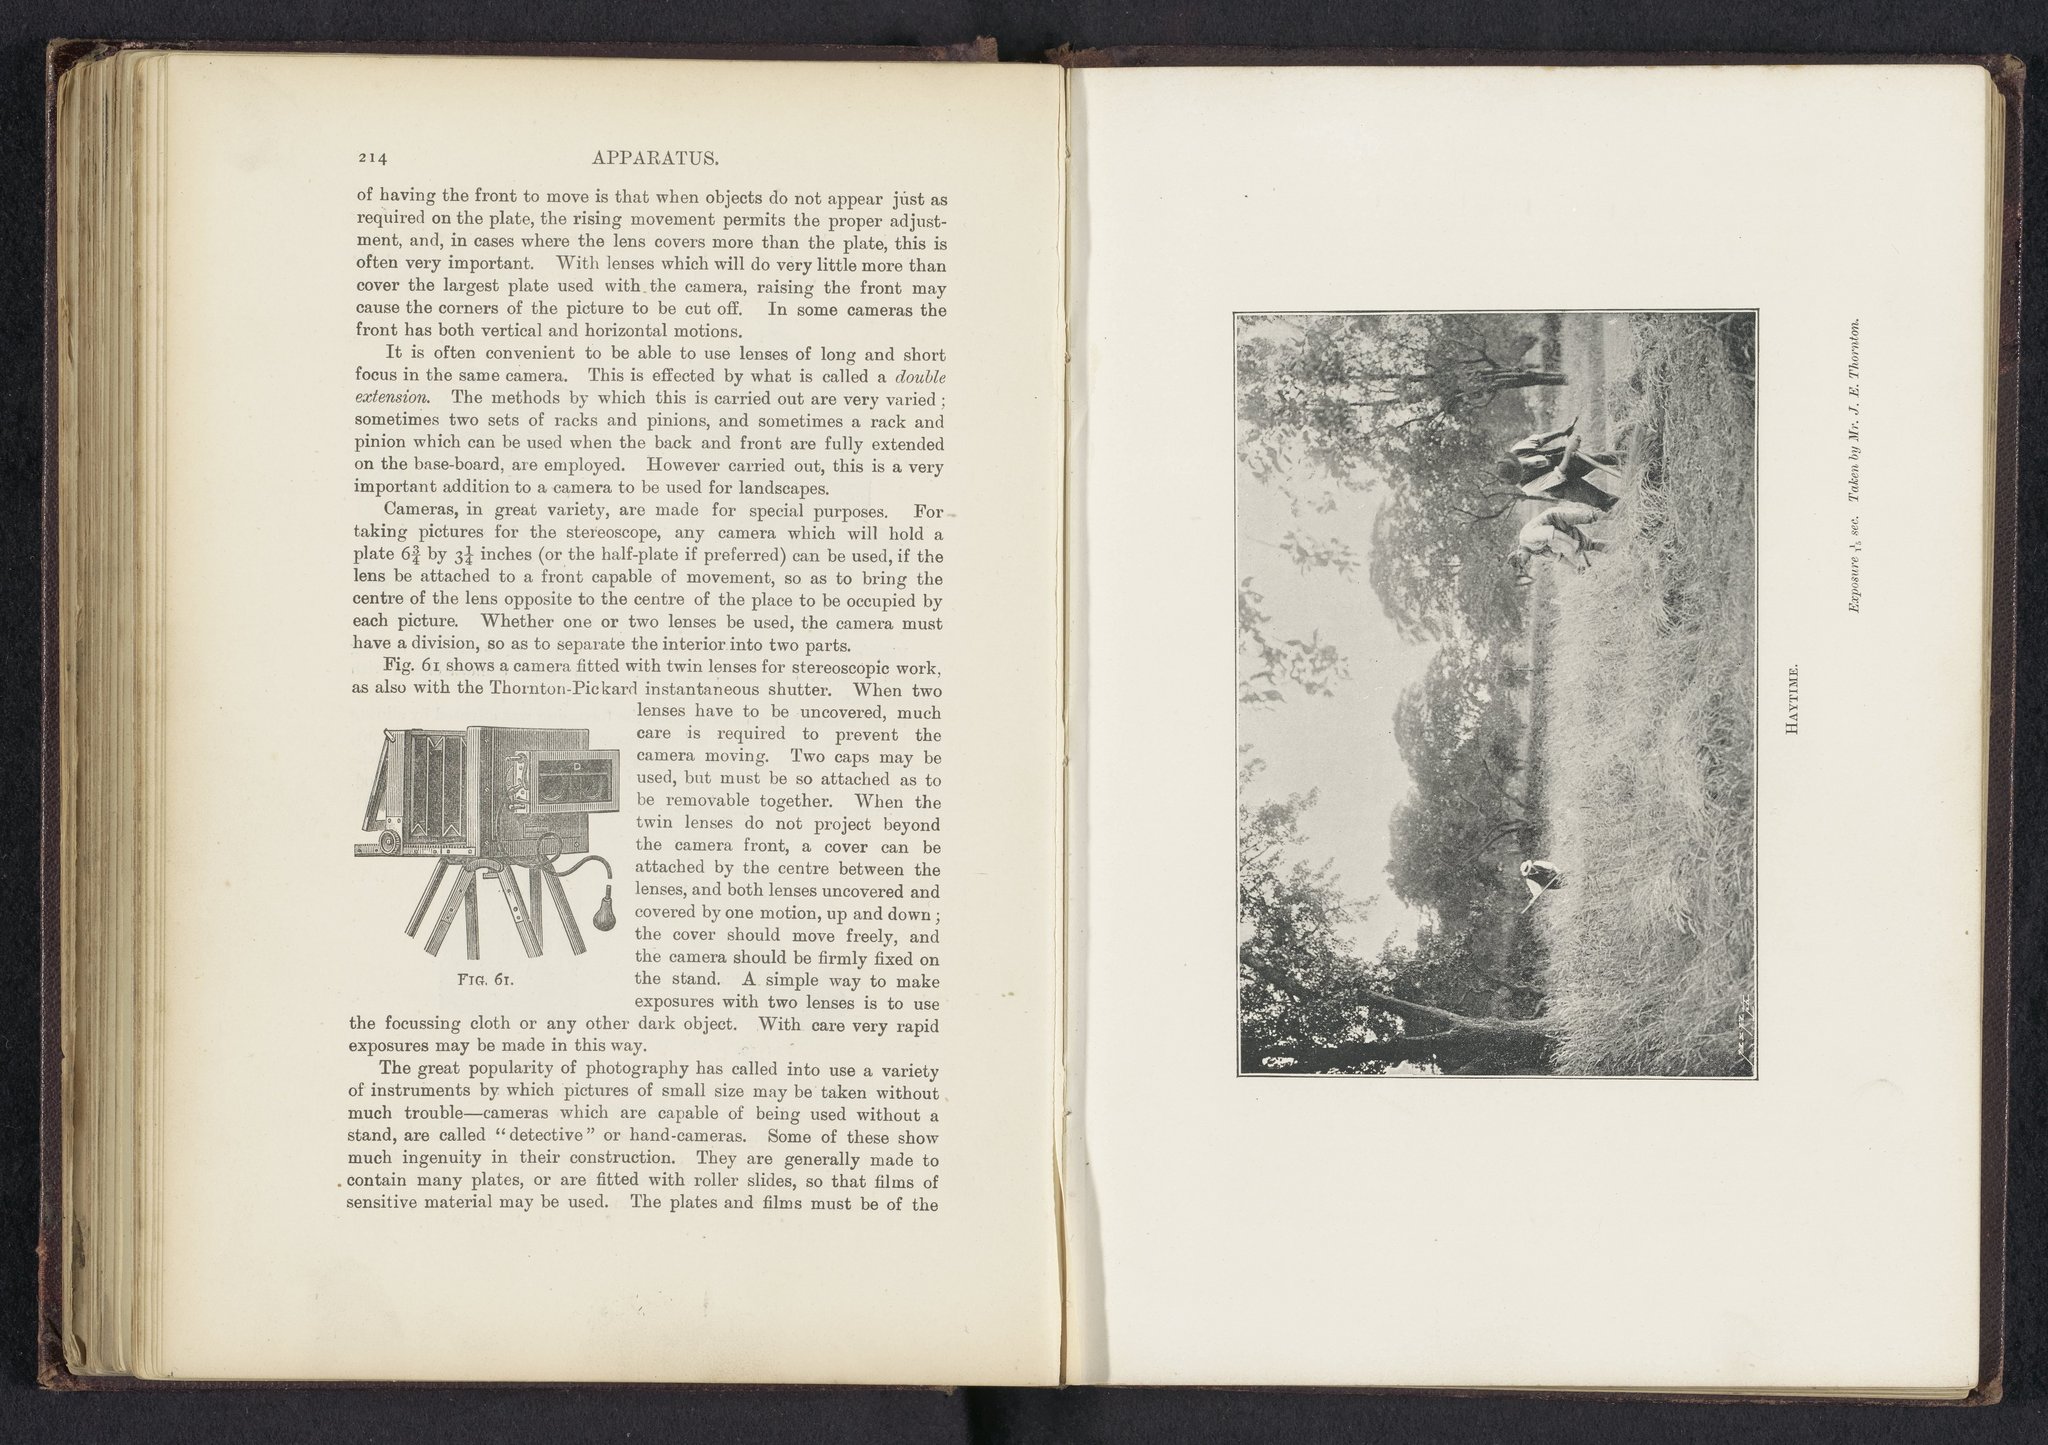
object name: page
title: Haytime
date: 1889-1899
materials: paper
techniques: autotype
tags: agricultural implements: scythe, reaping, picking, mowing ~ harvest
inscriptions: inscription: ‘Exposure 1/15 sec.’